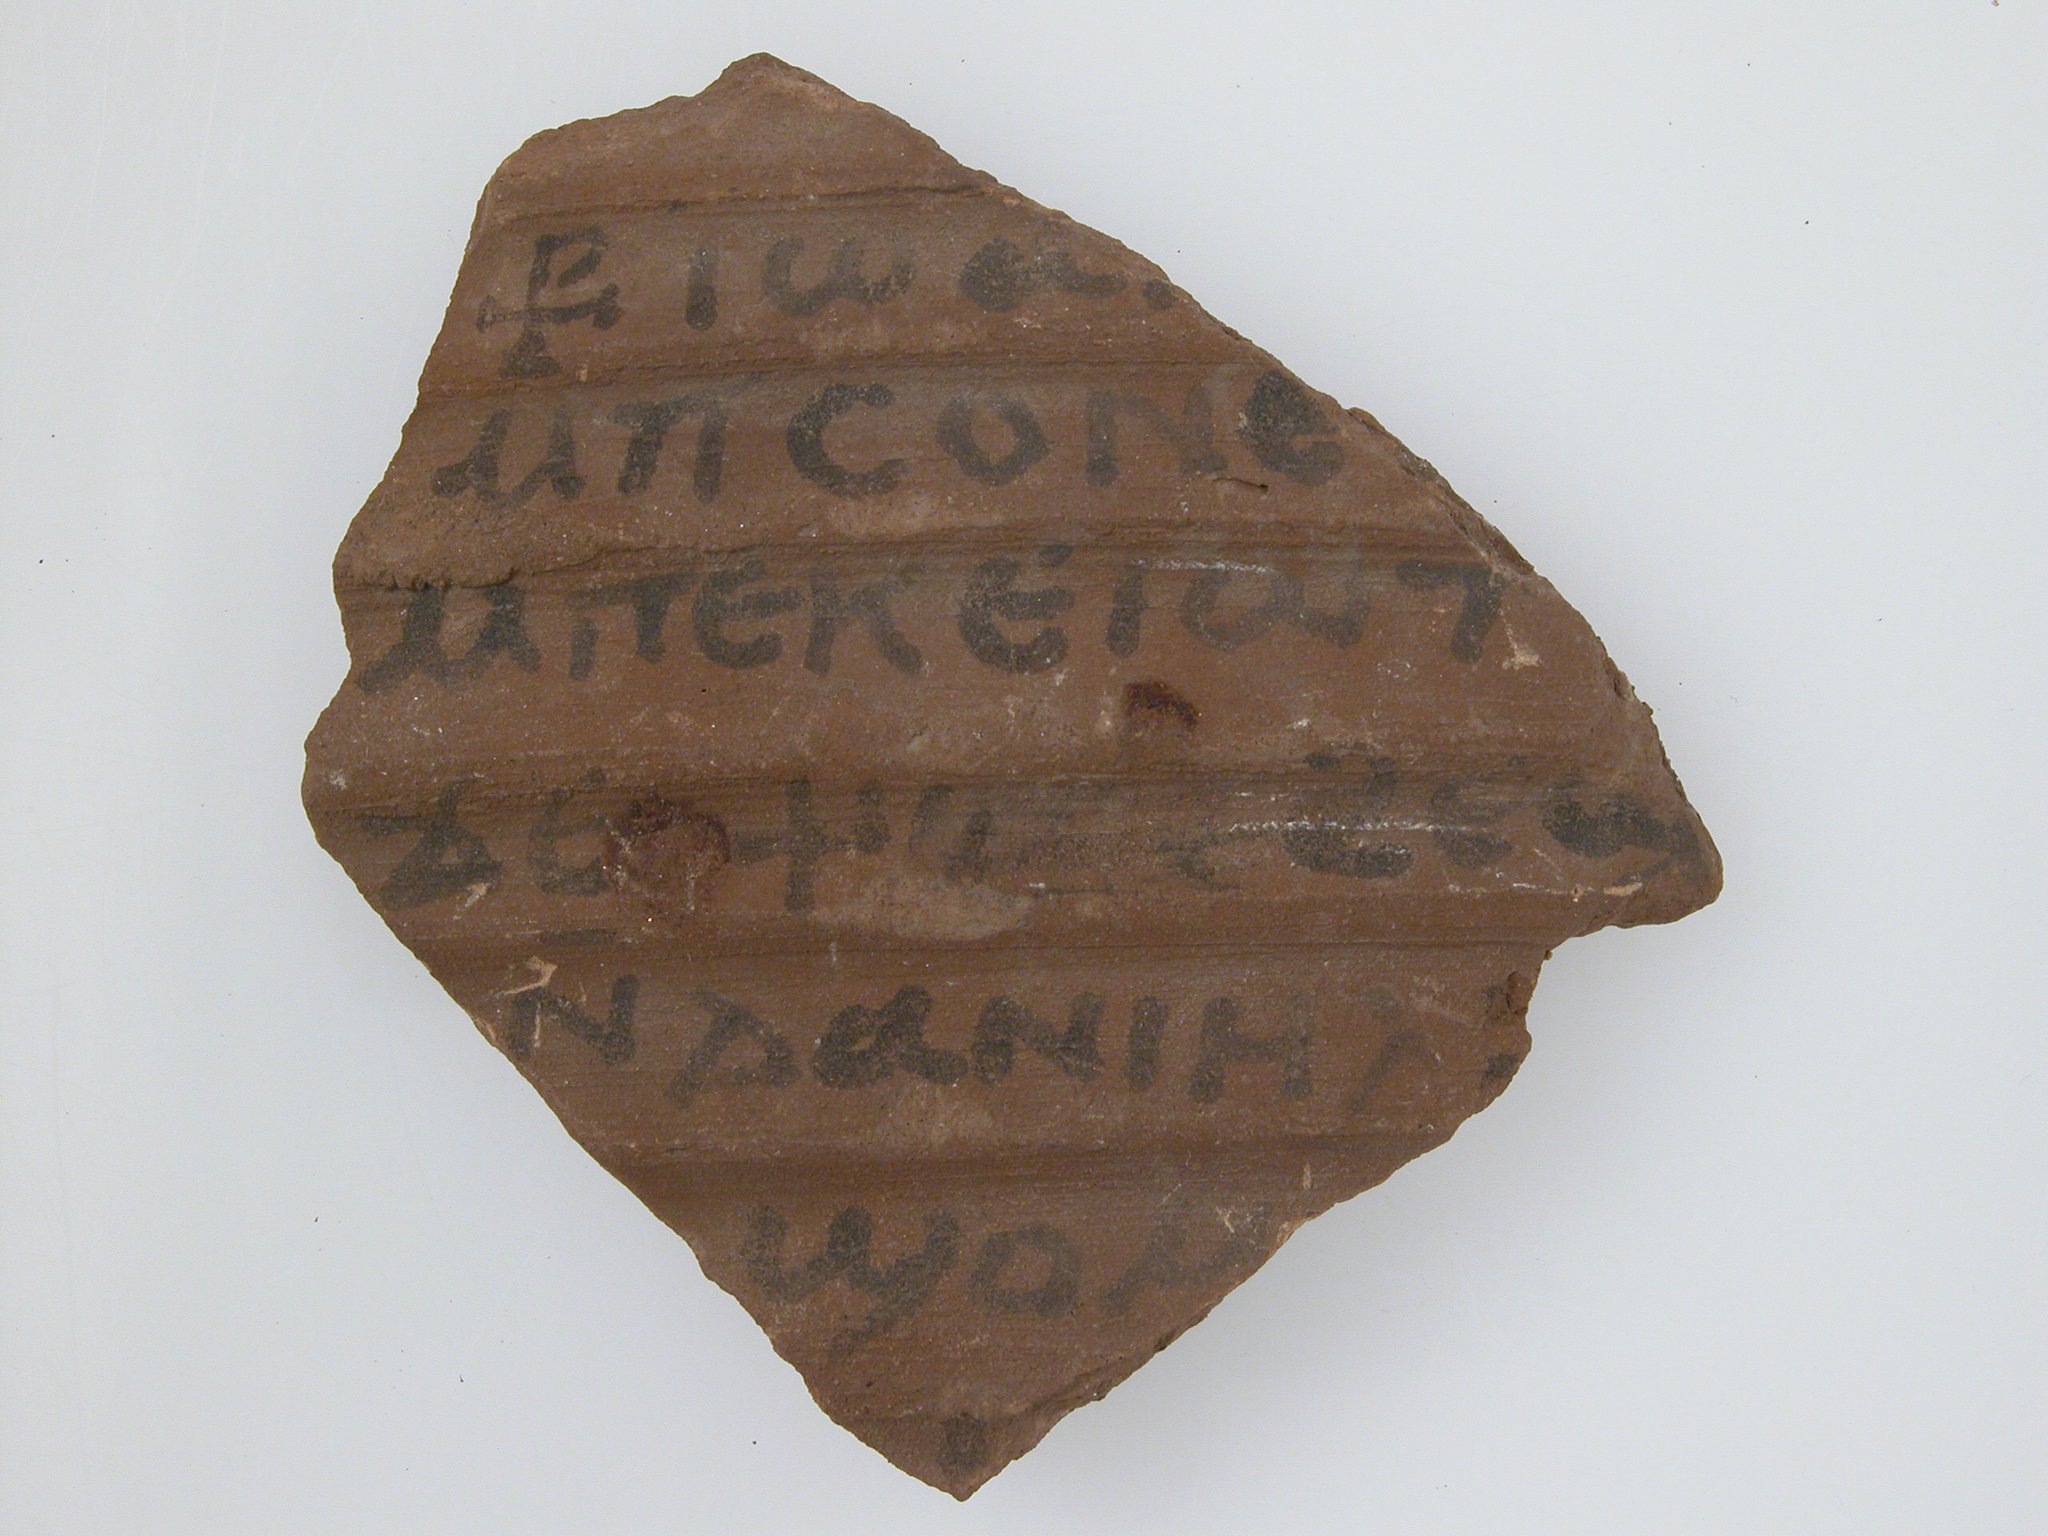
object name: ostrakon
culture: coptic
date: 580-640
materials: ink, pottery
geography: egypt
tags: coptic,documents